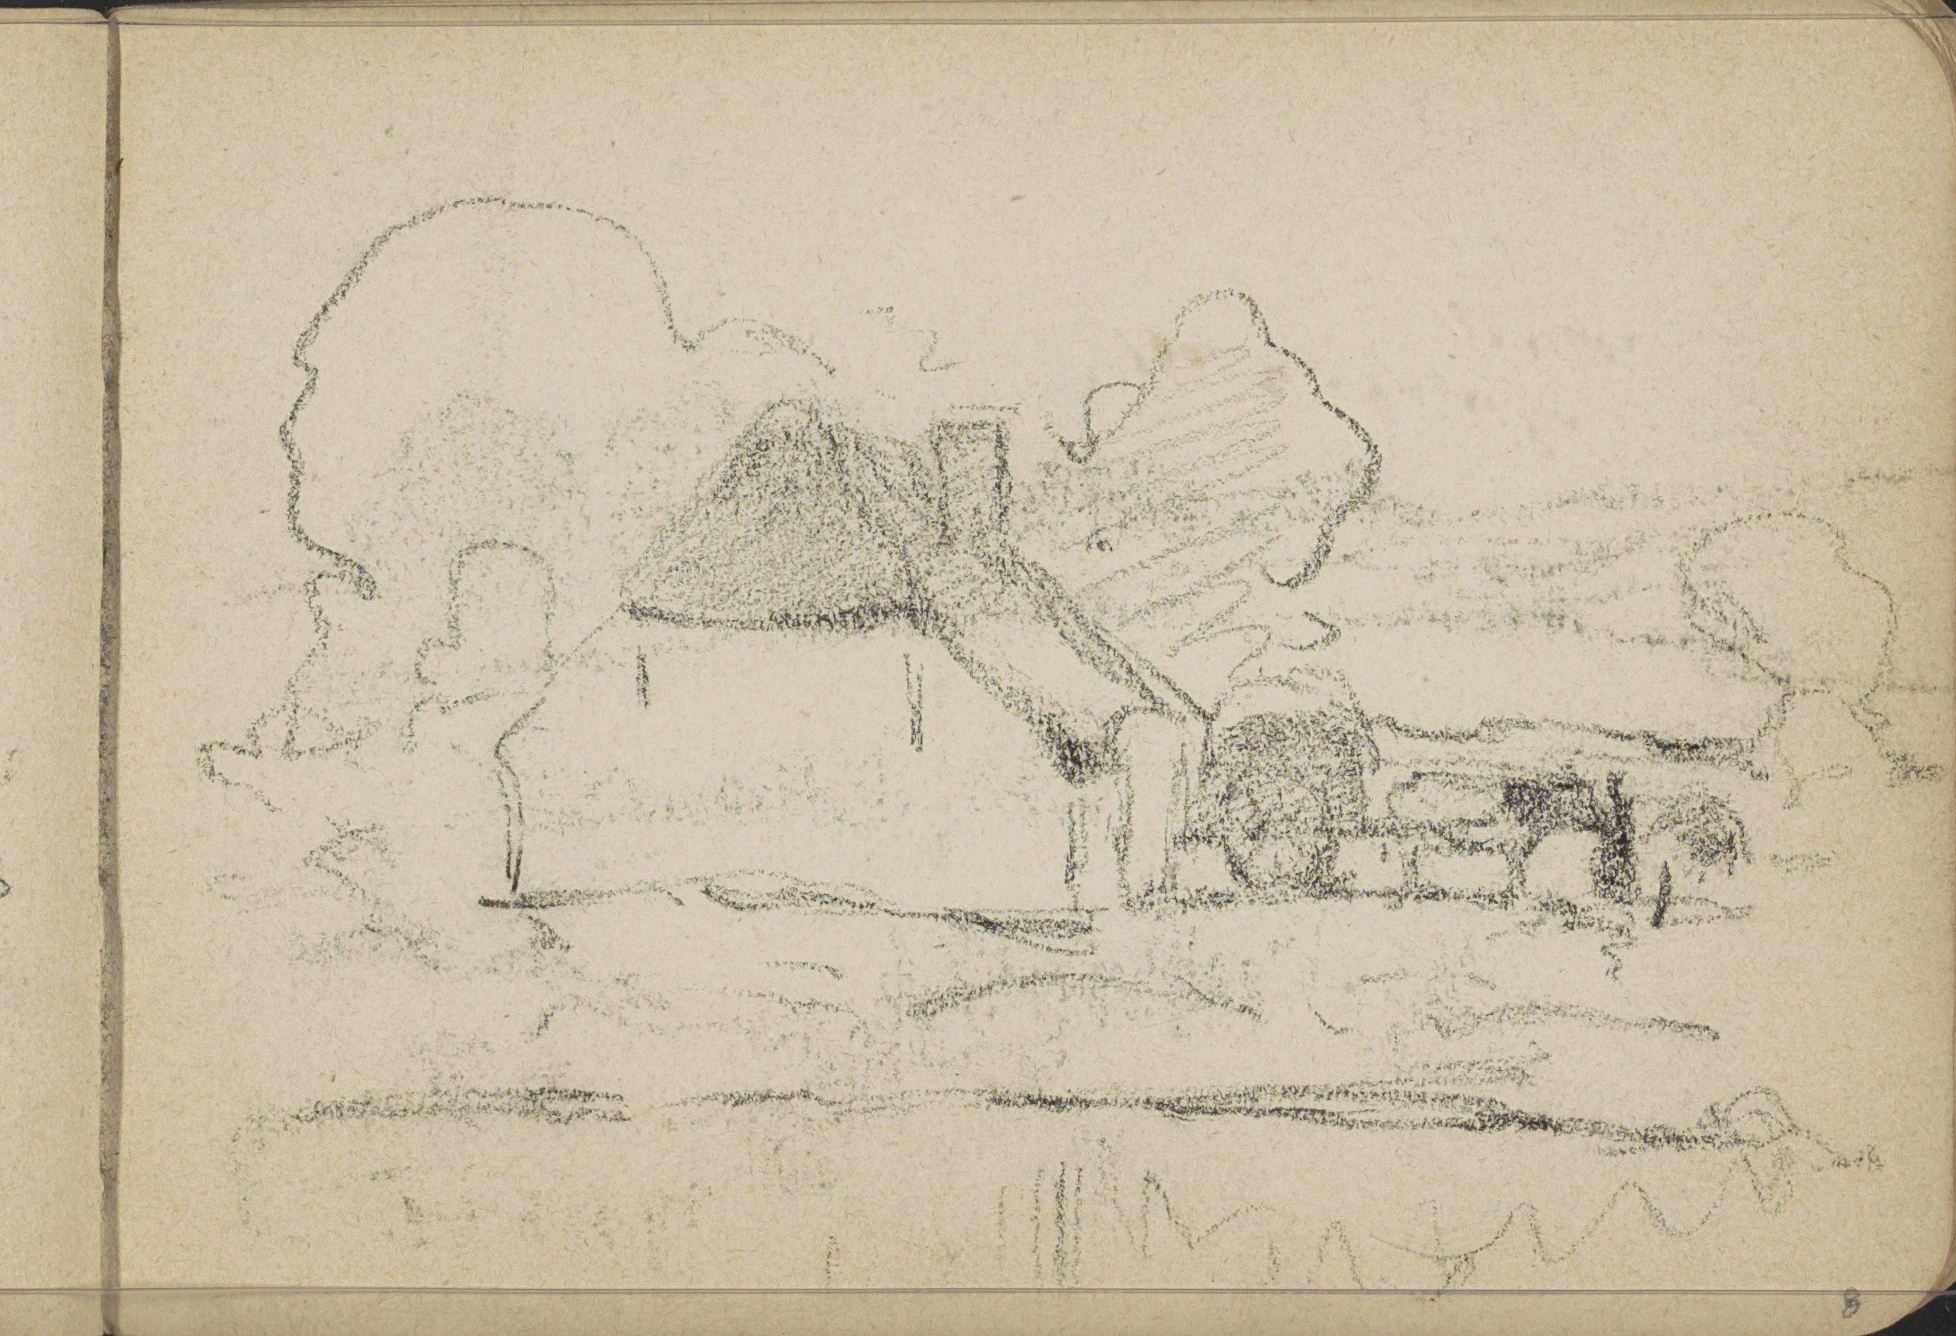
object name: sketchbook leaf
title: Boerderij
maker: willem cornelis rip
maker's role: draughtsman, painter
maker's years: 1856-1922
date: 1896-1897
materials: chalk, paper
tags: farm (building)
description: Blad 8 recto uit een schetsboek met 44 bladen.